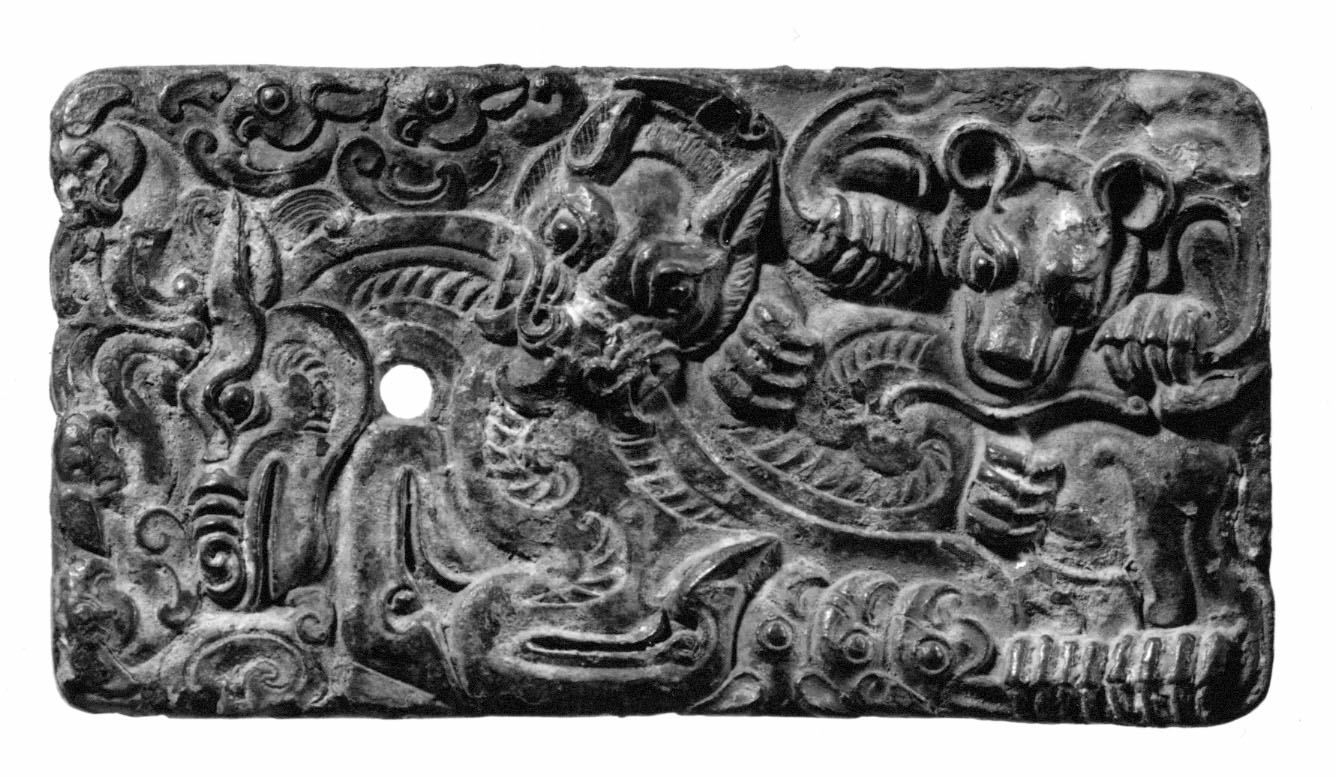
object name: belt buckle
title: Belt Buckle with Animal Combat Scene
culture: chinese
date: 300-101 BCE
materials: bronze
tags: animals